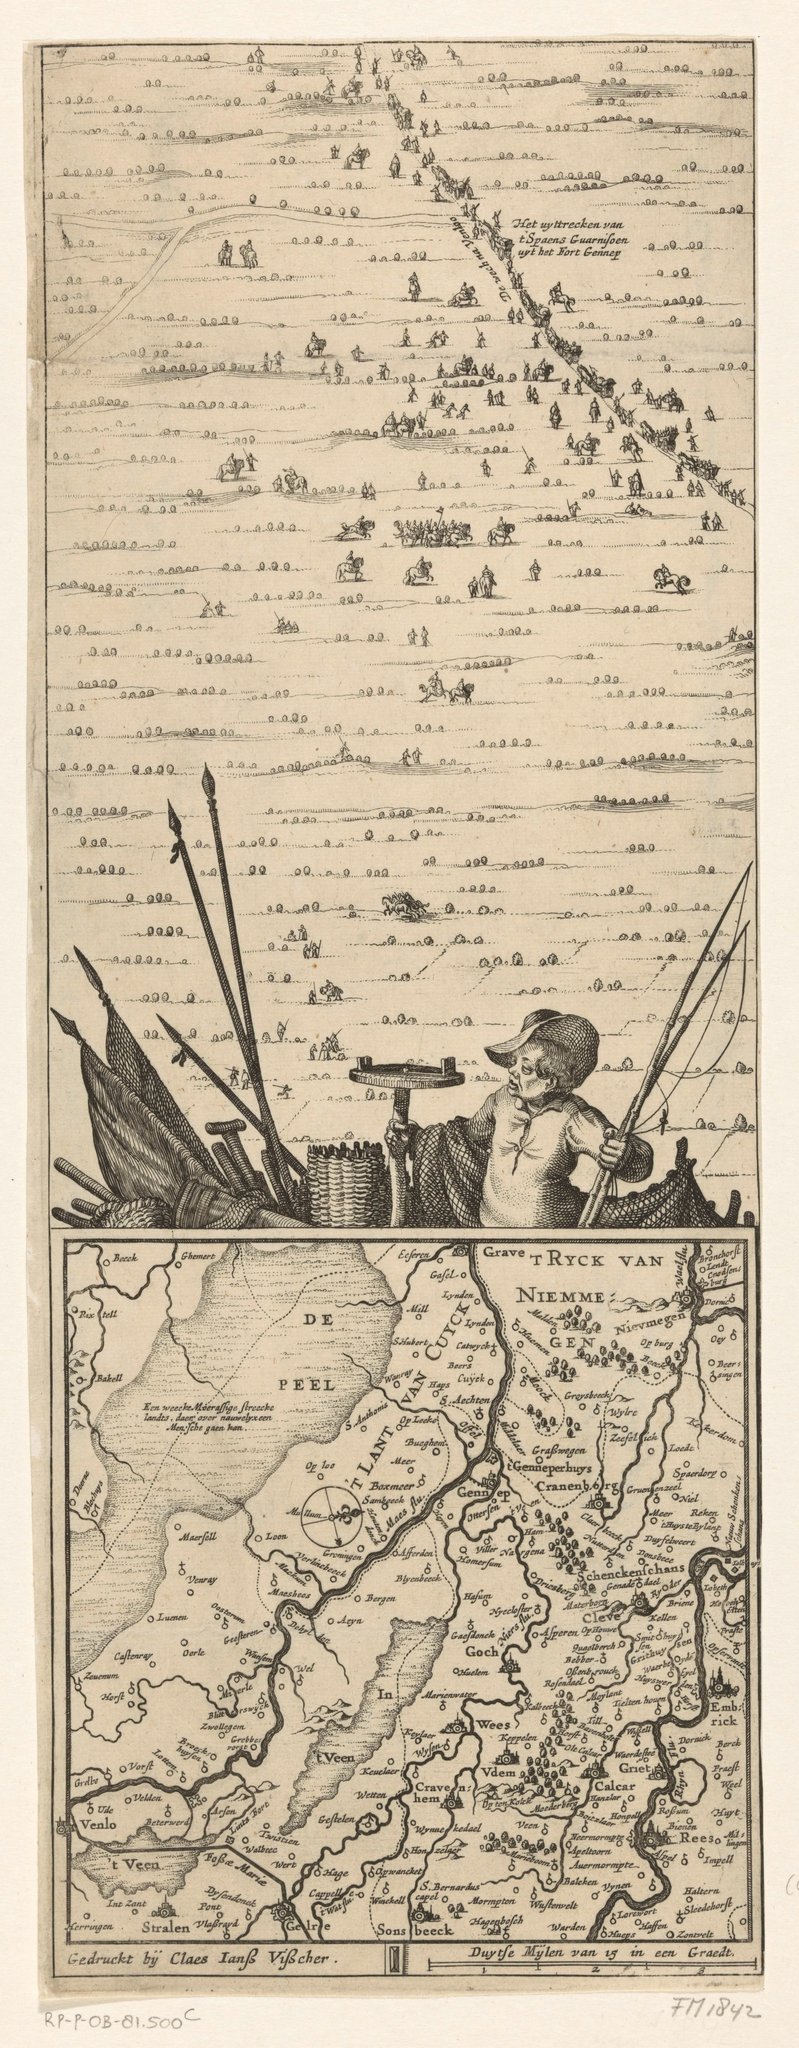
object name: map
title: Kaart van het beleg van Huis te Gennep (zijblad), 1641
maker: claes jansz. visscher (ii)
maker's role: draughtsman, print maker, publisher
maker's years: 1586-1652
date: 1641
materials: paper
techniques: etching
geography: amsterdam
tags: delft, the hague, frederick henry (prince of orange), maps of separate countries or regions, siege, position war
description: Kaart van Gennep met het Huis te Gennep en omgeving, belegerd en veroverd door het Staatse leger onder Frederik Hendrik, 6 juni - 27 juli 1641. Met de circumvallatielinie van de belegeraars en de hun legerkampen. Linker zijblad met een inzet met een kaart van het groter gebied in Limburg en een vissertje. Onderdeel van een ensemble bestaande uit een titel in 4 stroken, de 4 platen uit het atelier van Visscher, de 4 bladen van het vertrek van het garnizoen door Nolpe en 7 tekstbladen.